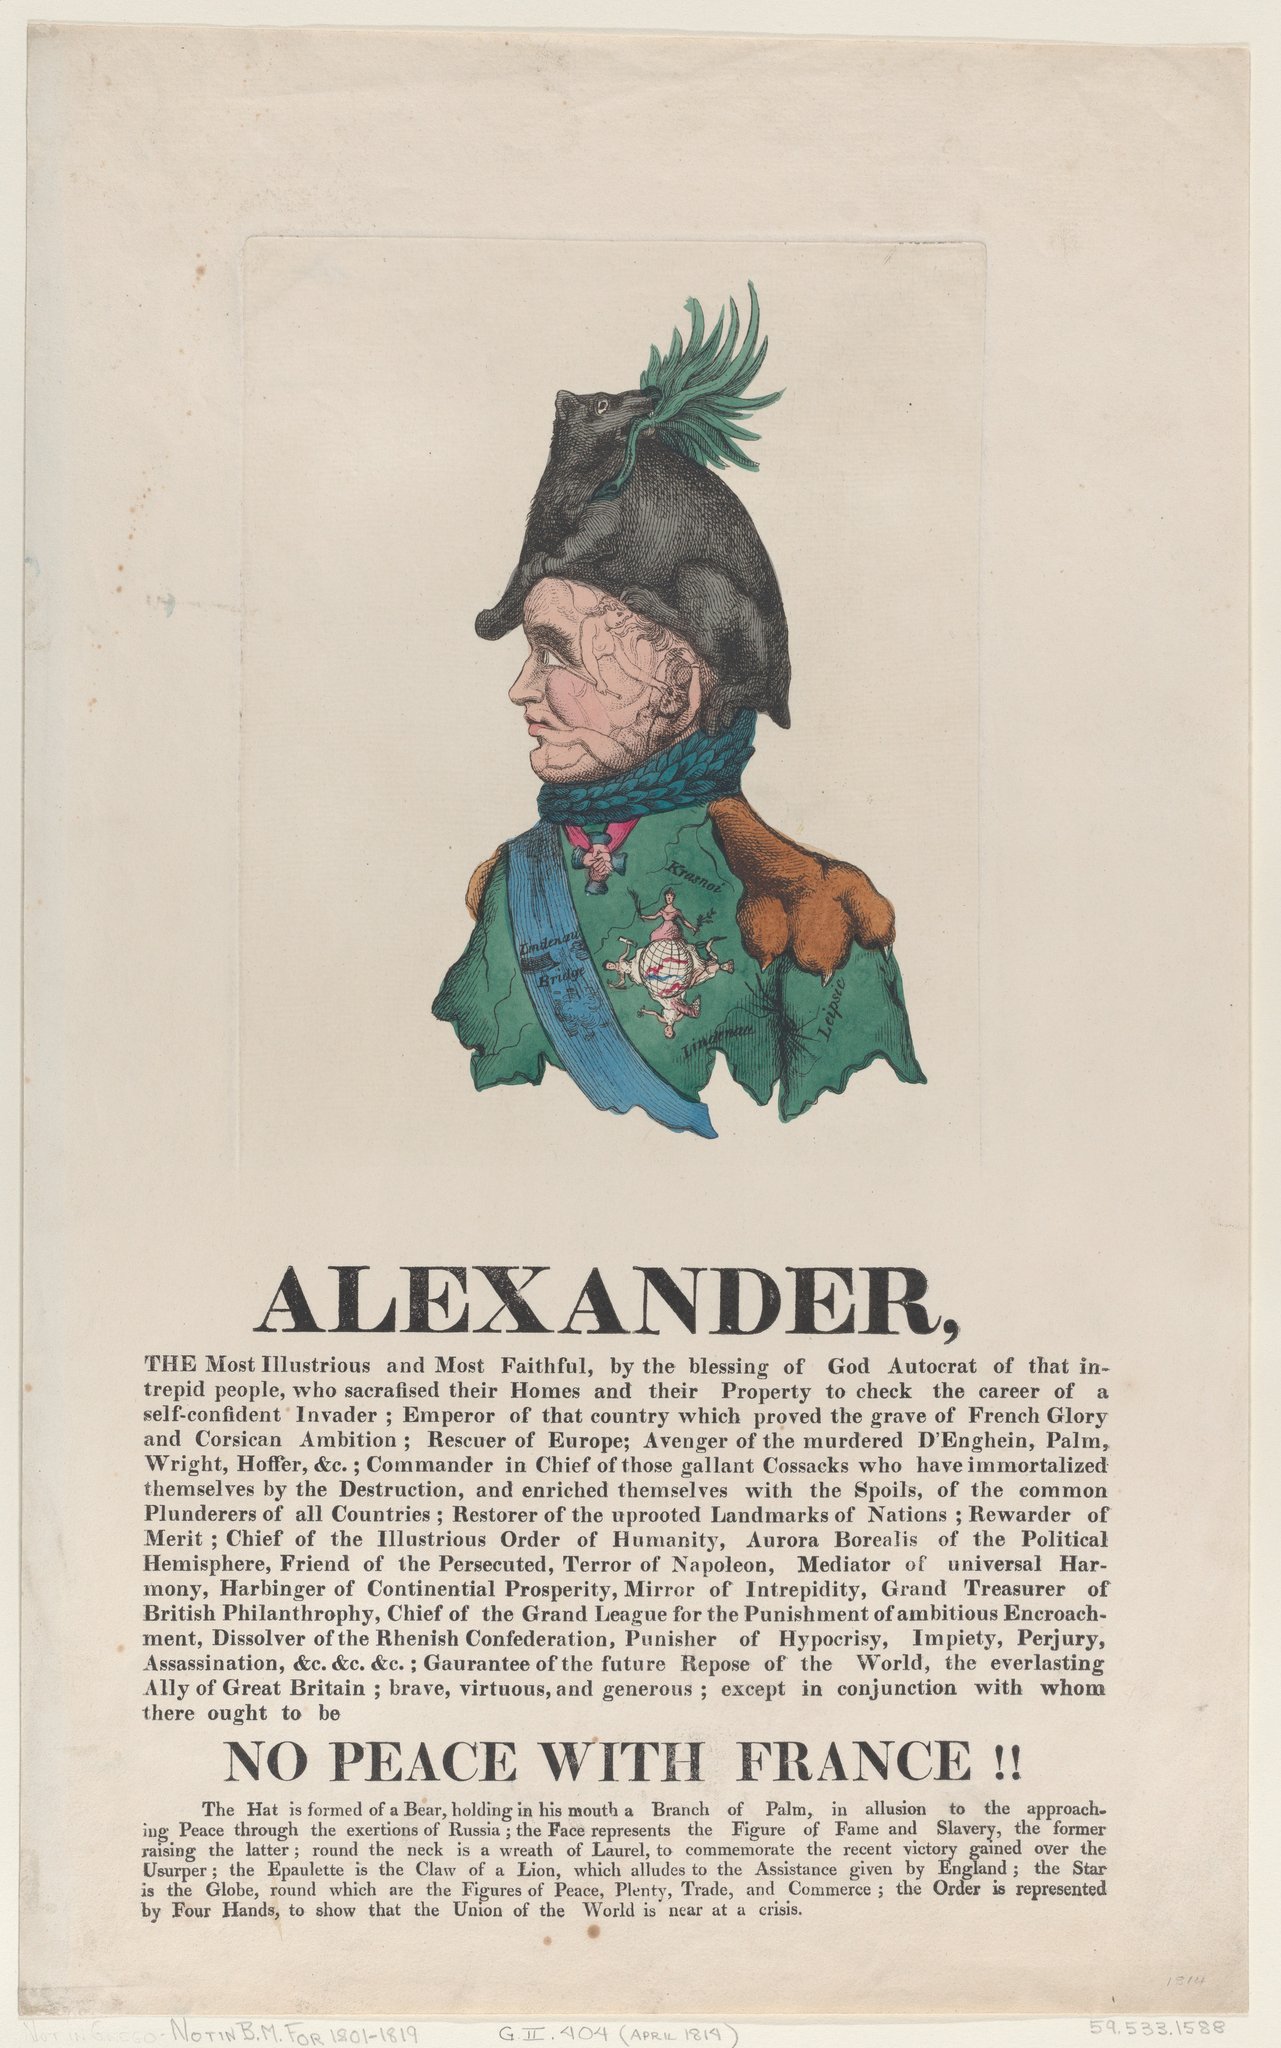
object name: print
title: Alexander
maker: thomas rowlandson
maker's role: artist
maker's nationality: british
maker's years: 1757-1827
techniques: etching, letterpress